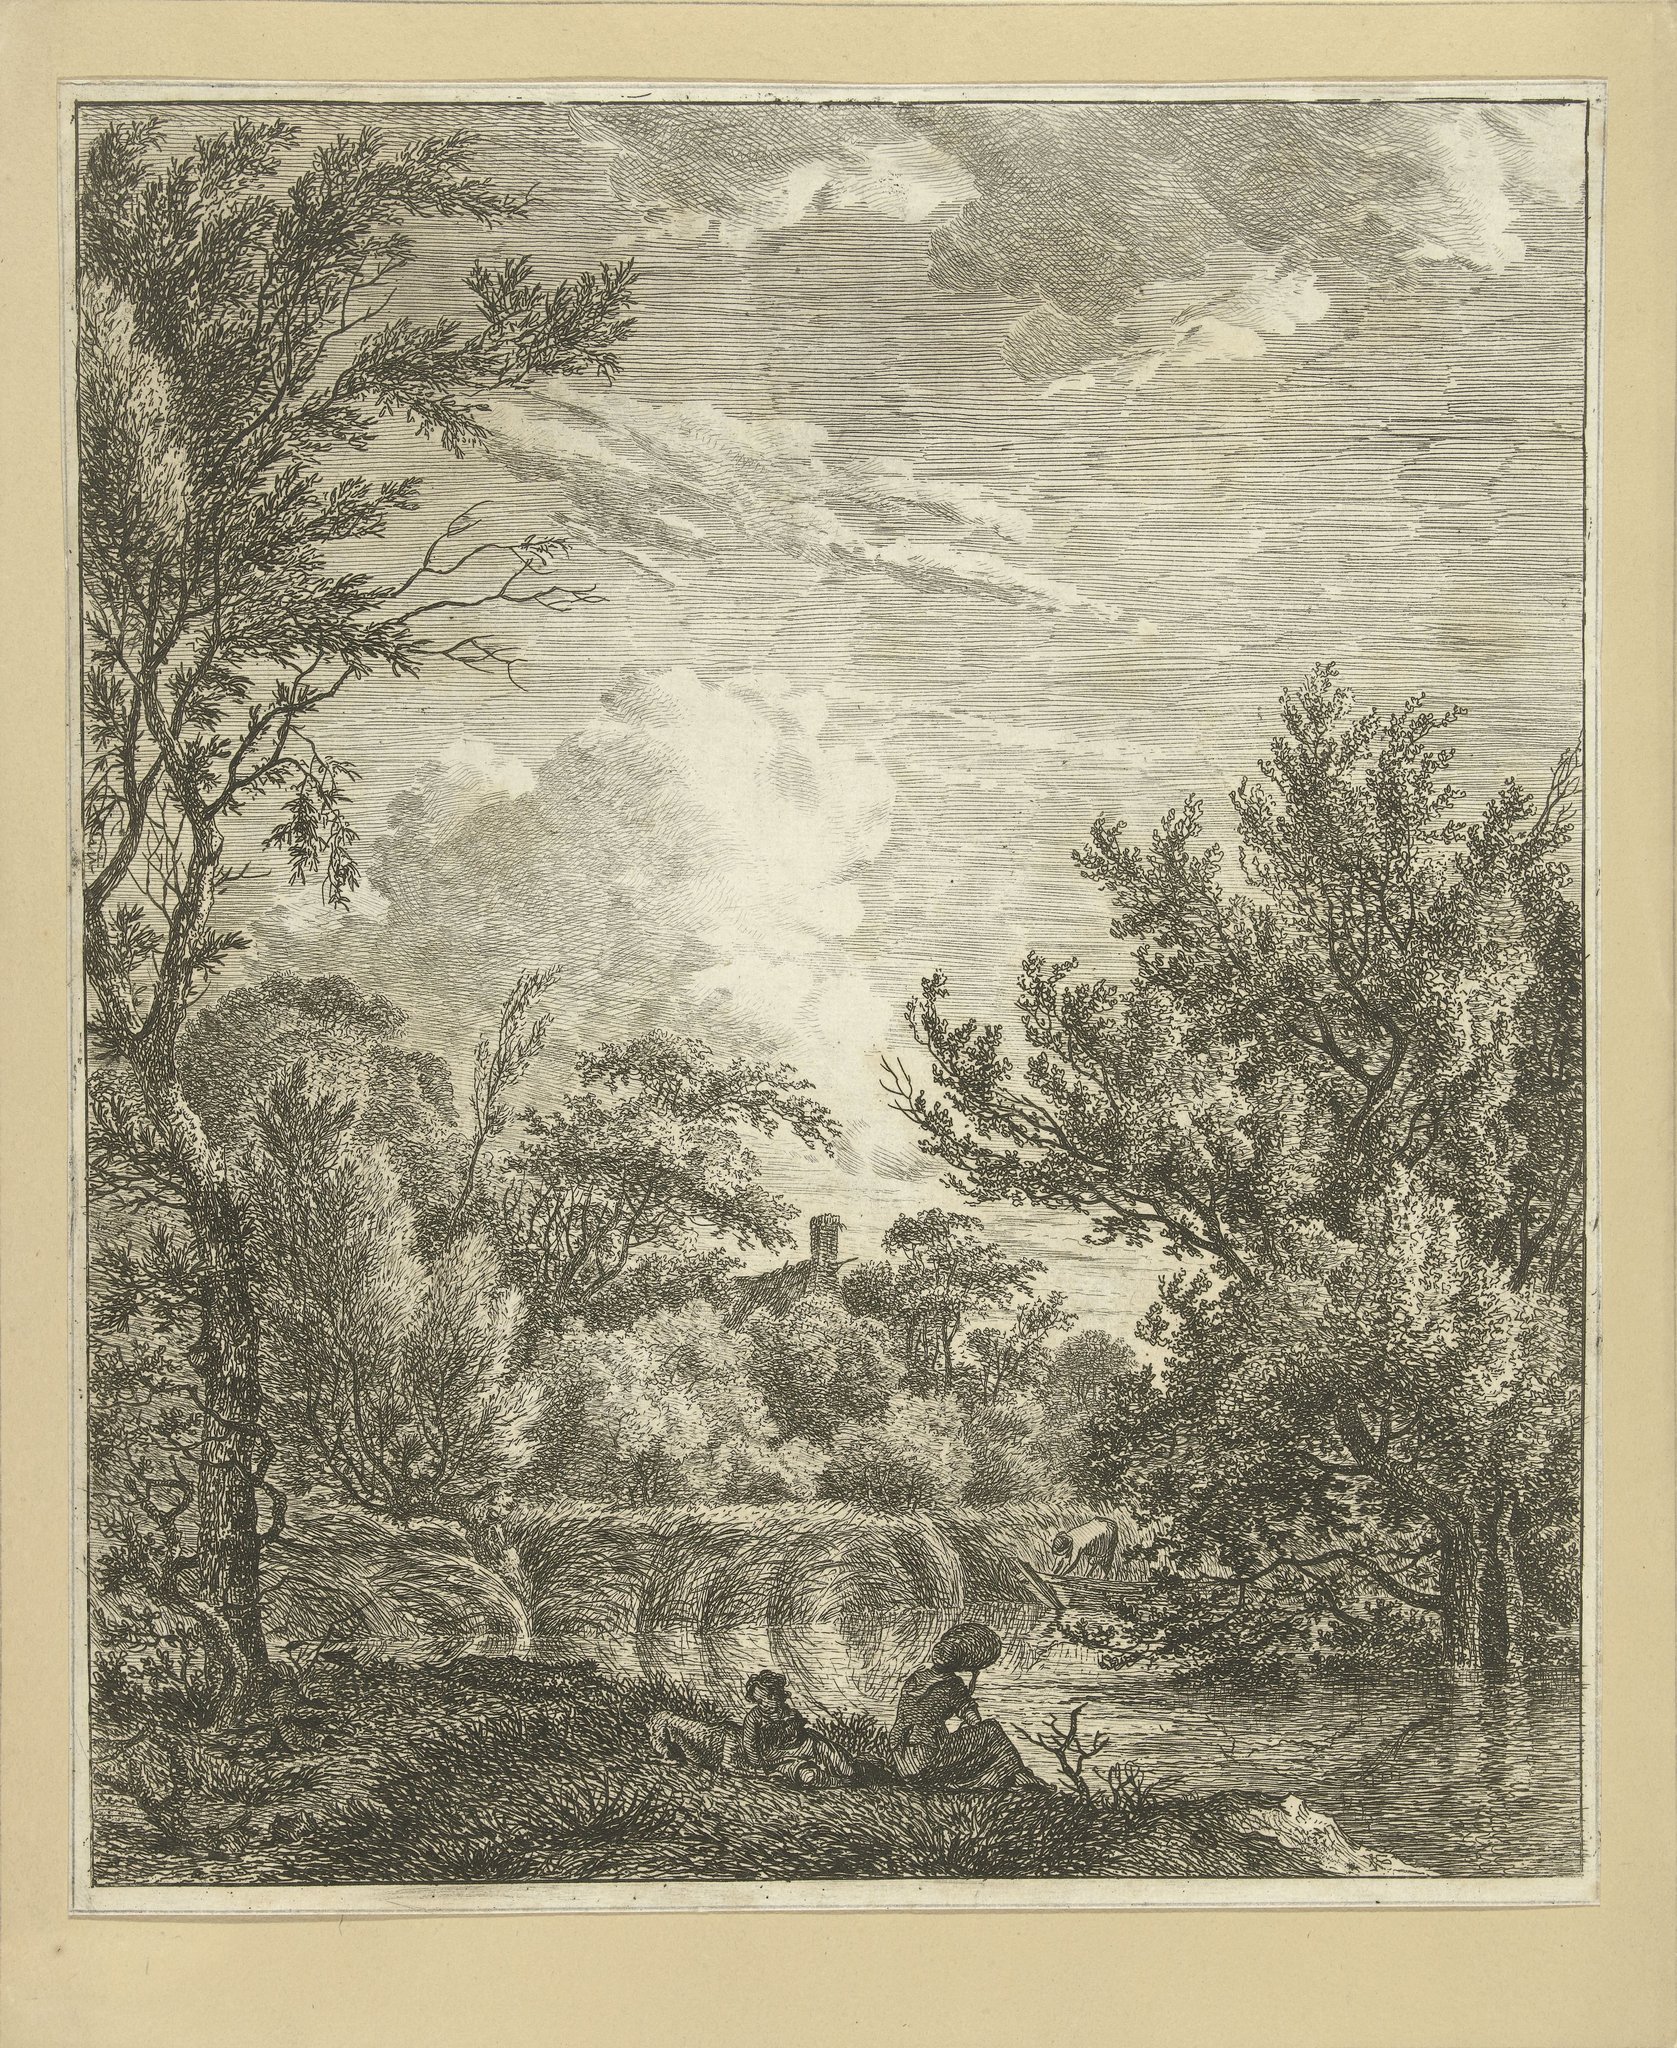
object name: print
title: Landschap met vrouw aan waterkant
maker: hermanus fock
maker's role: conservator, draughtsman, painter, print maker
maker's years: 1766-1822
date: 1781-1822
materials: paper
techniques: etching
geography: amsterdam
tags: rowing-boat, canoe, etc., river bank (+ landscape with figures, staffage)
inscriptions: collector's mark: Lugt 924, collector's mark: Lugt 2228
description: Een landschap met hoge bomen en een man in een roeiboot op het water. In het gras langs de waterkant zit een vrouw en een kind met een hond. Boven de bomen op de achtergrond steekt een dak uit.